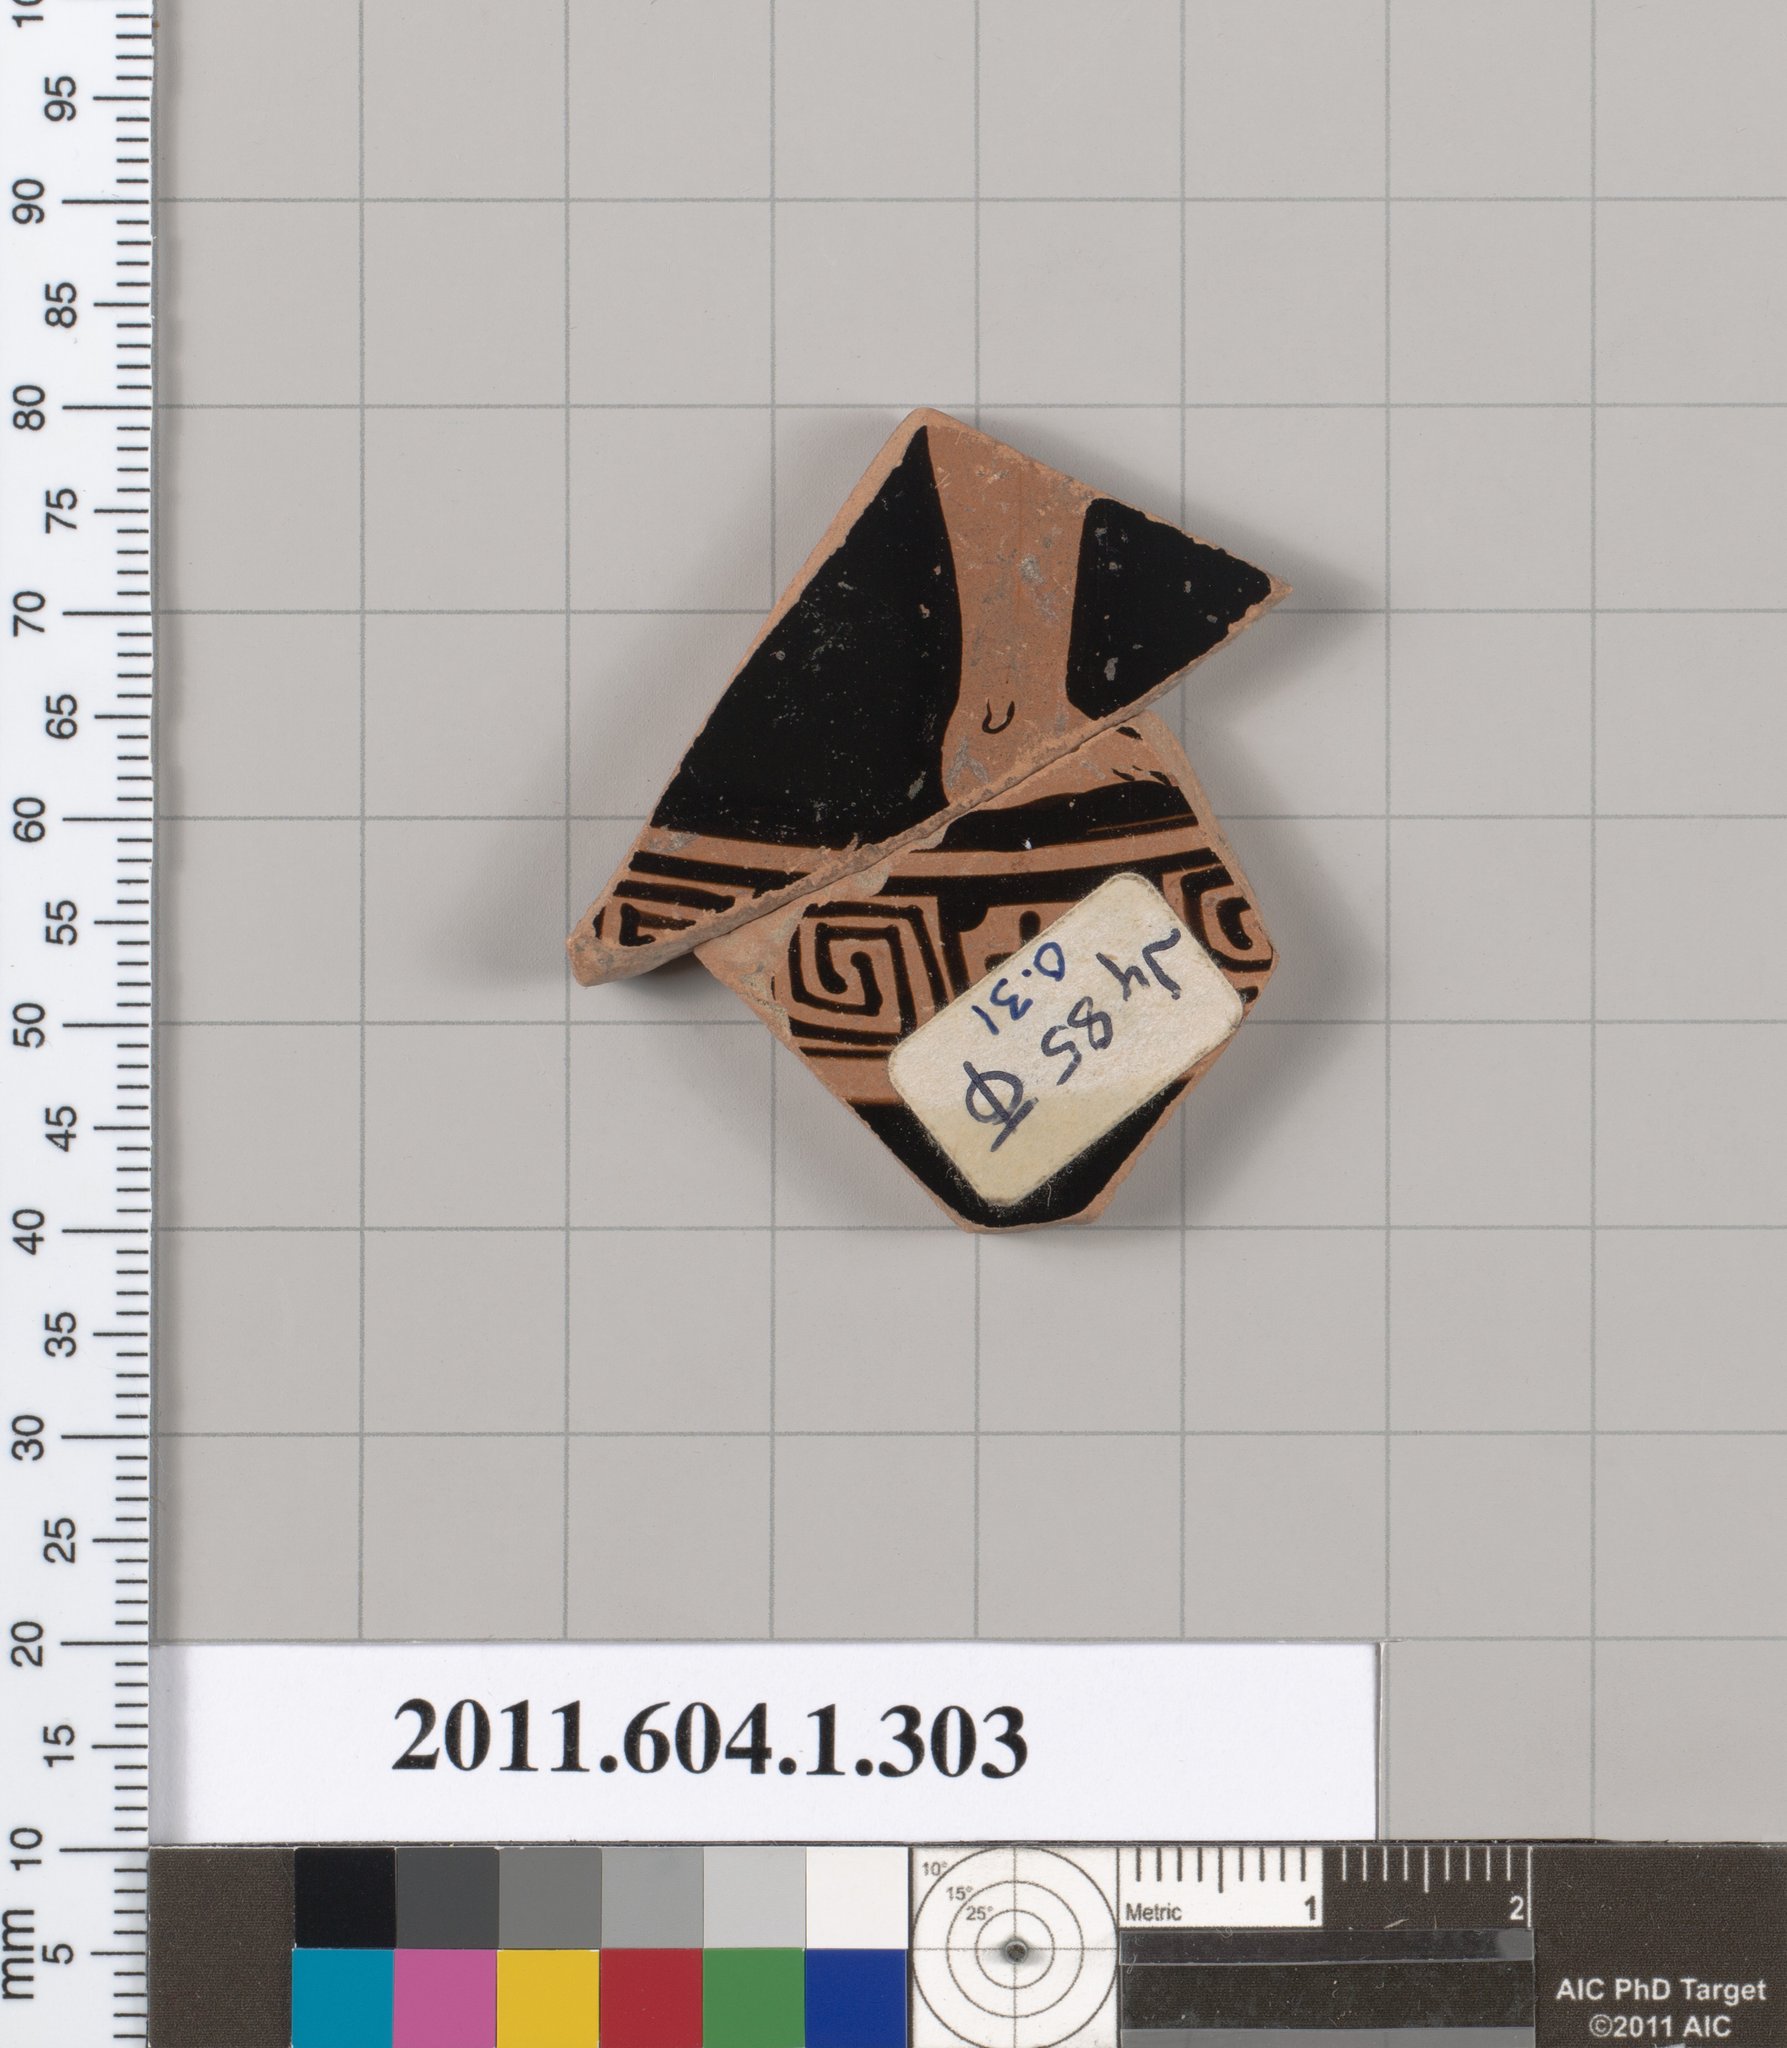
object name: kylix fragment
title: Terracotta fragment of a kylix (drinking cup)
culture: greek, attic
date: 475-451 BCE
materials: terracotta